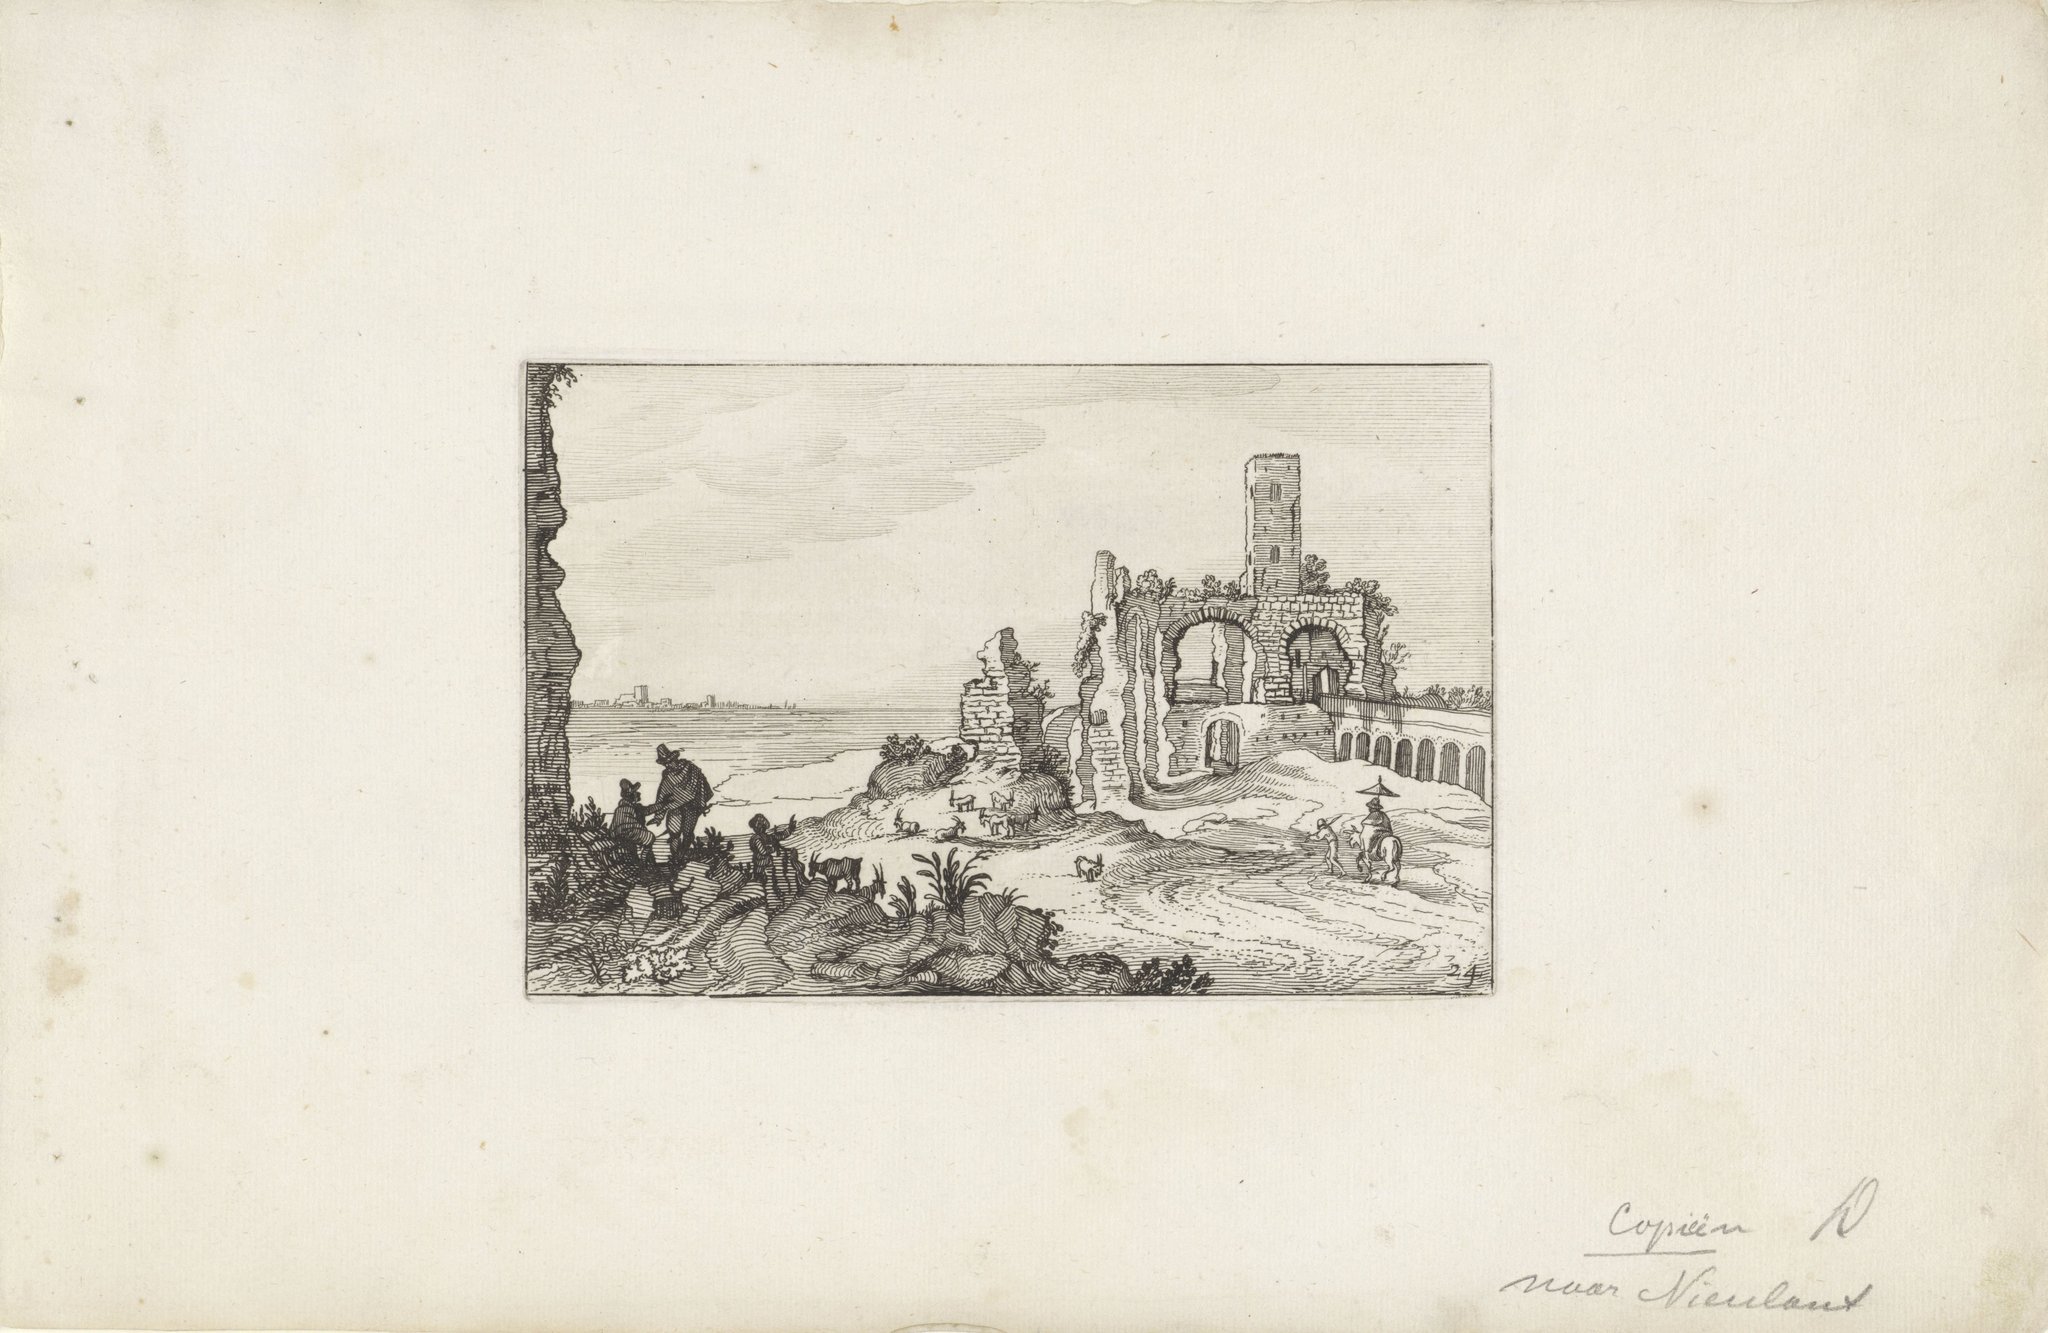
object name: print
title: Variae antiquitates Romanae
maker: claes jansz. visscher (ii)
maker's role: draughtsman, print maker, publisher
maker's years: 1586-1652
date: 1618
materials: paper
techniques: etching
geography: amsterdam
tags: riding a horse, ass, or mule; rider, horseman, landscape with ruins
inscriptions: collector's mark: Lugt 2233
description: Een ruïne met bogen en een toren aan het water. Rechts een wandelaar en een man op een ezel. Links op de voorgrond drie figuren en geiten.